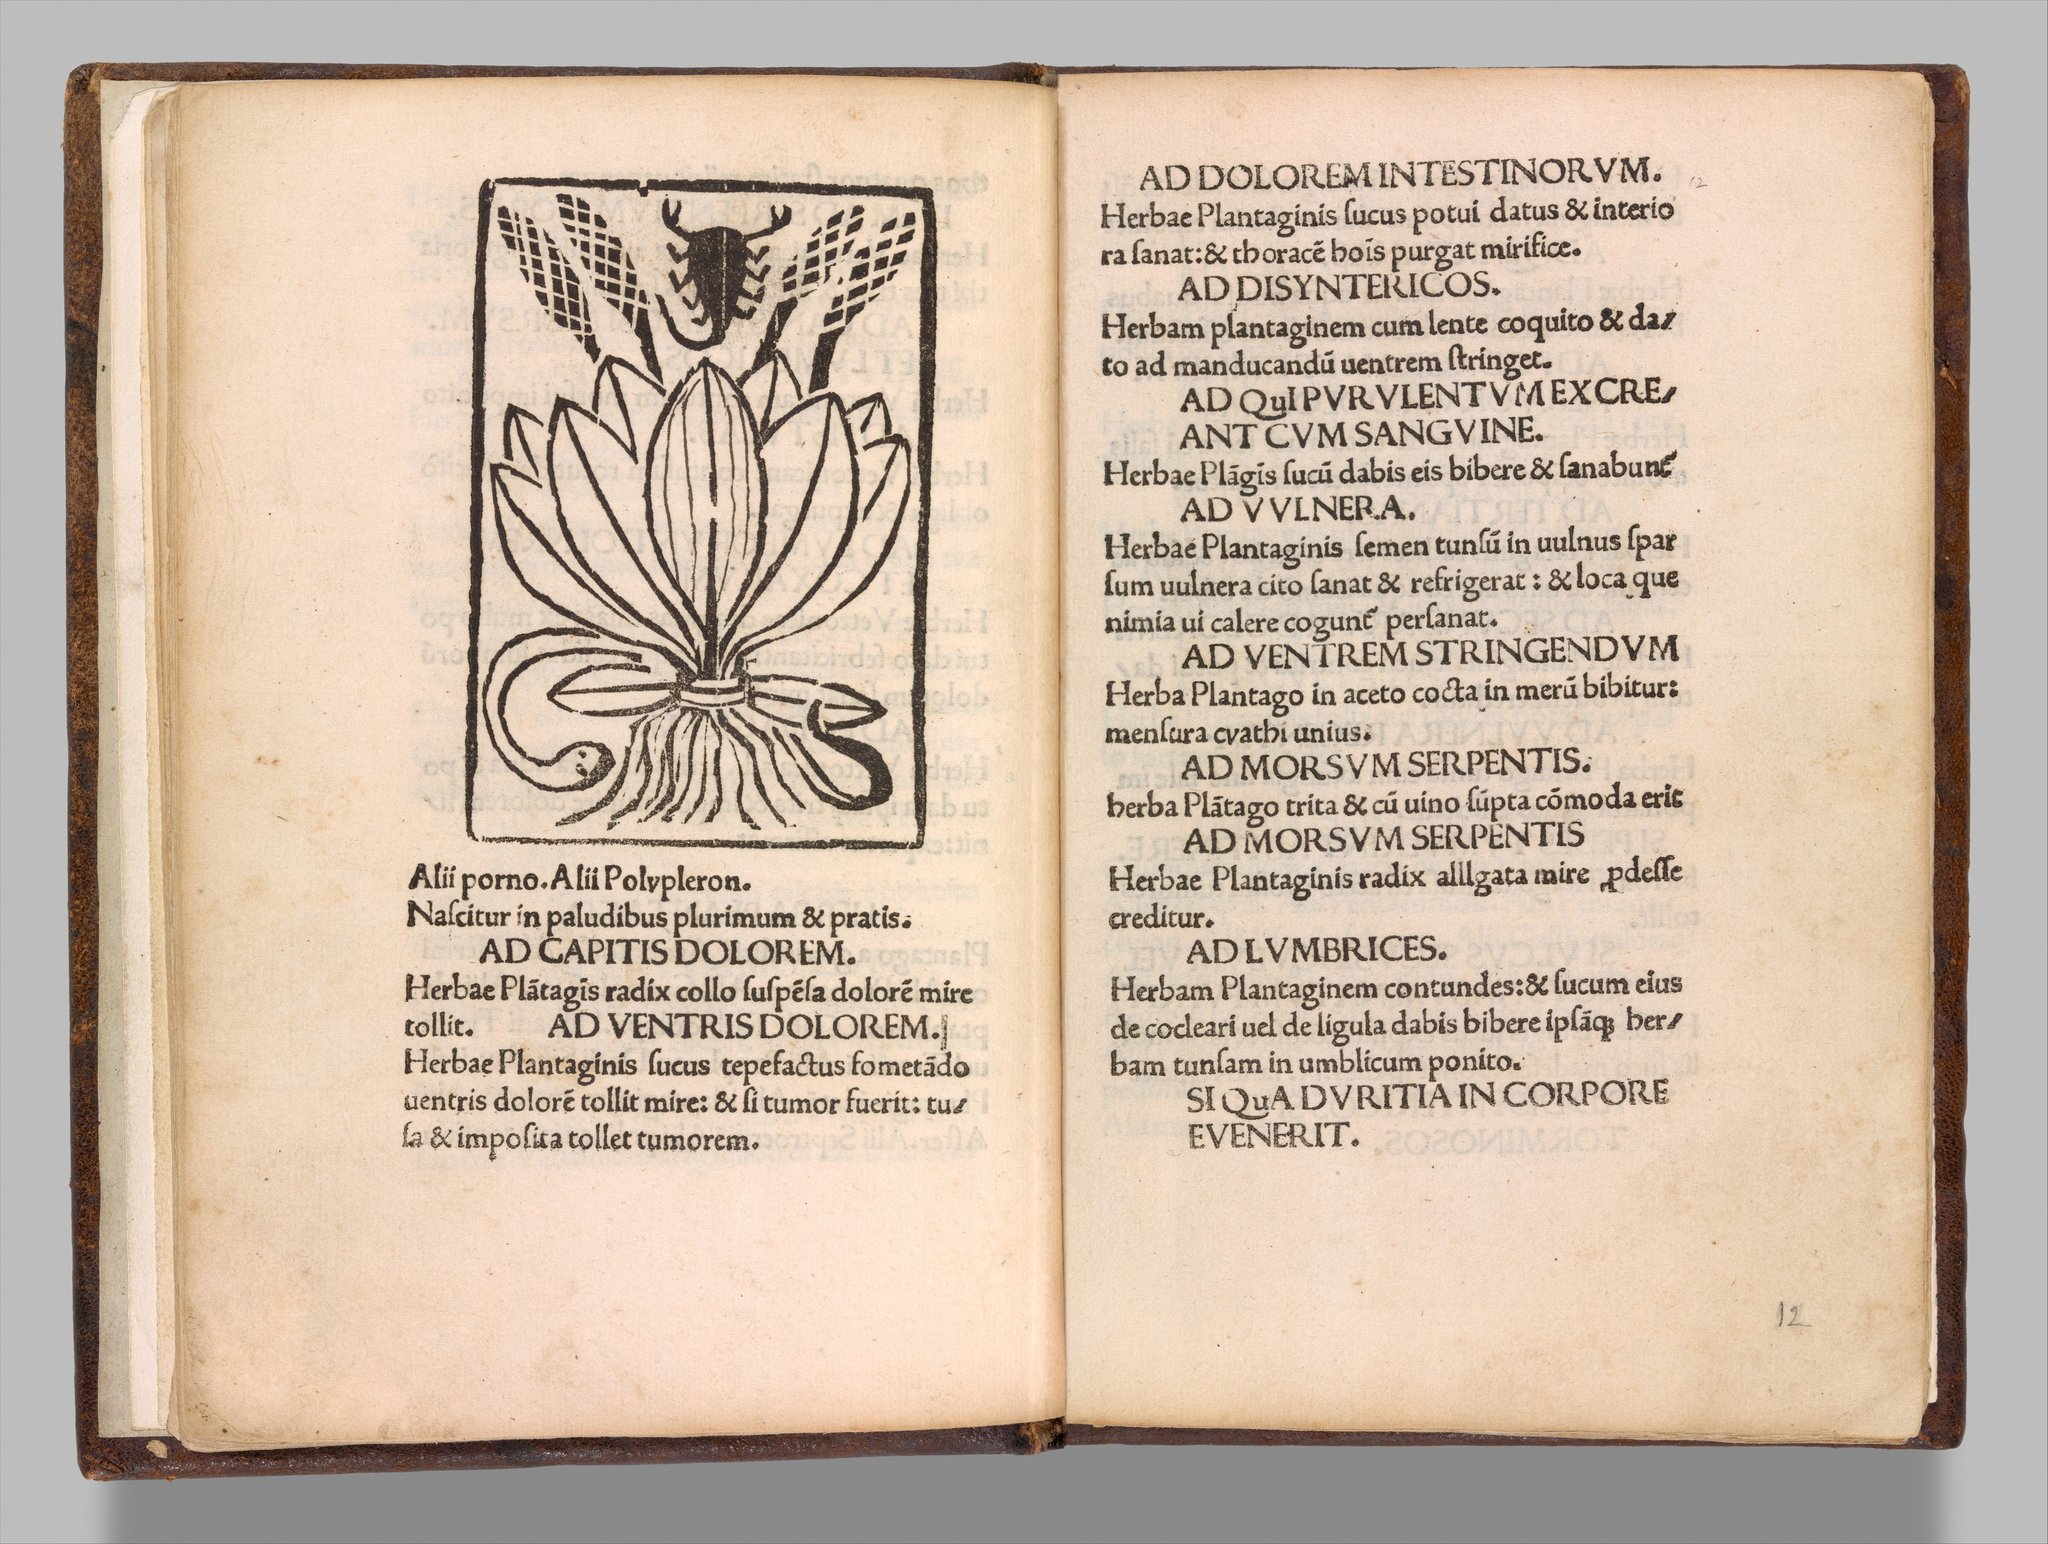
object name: book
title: Herbarium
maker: pseudo-apuleius platonicus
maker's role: author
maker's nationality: north african (?)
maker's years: 300-400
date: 1483-1484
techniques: hand coloring, woodcut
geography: italy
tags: scorpions